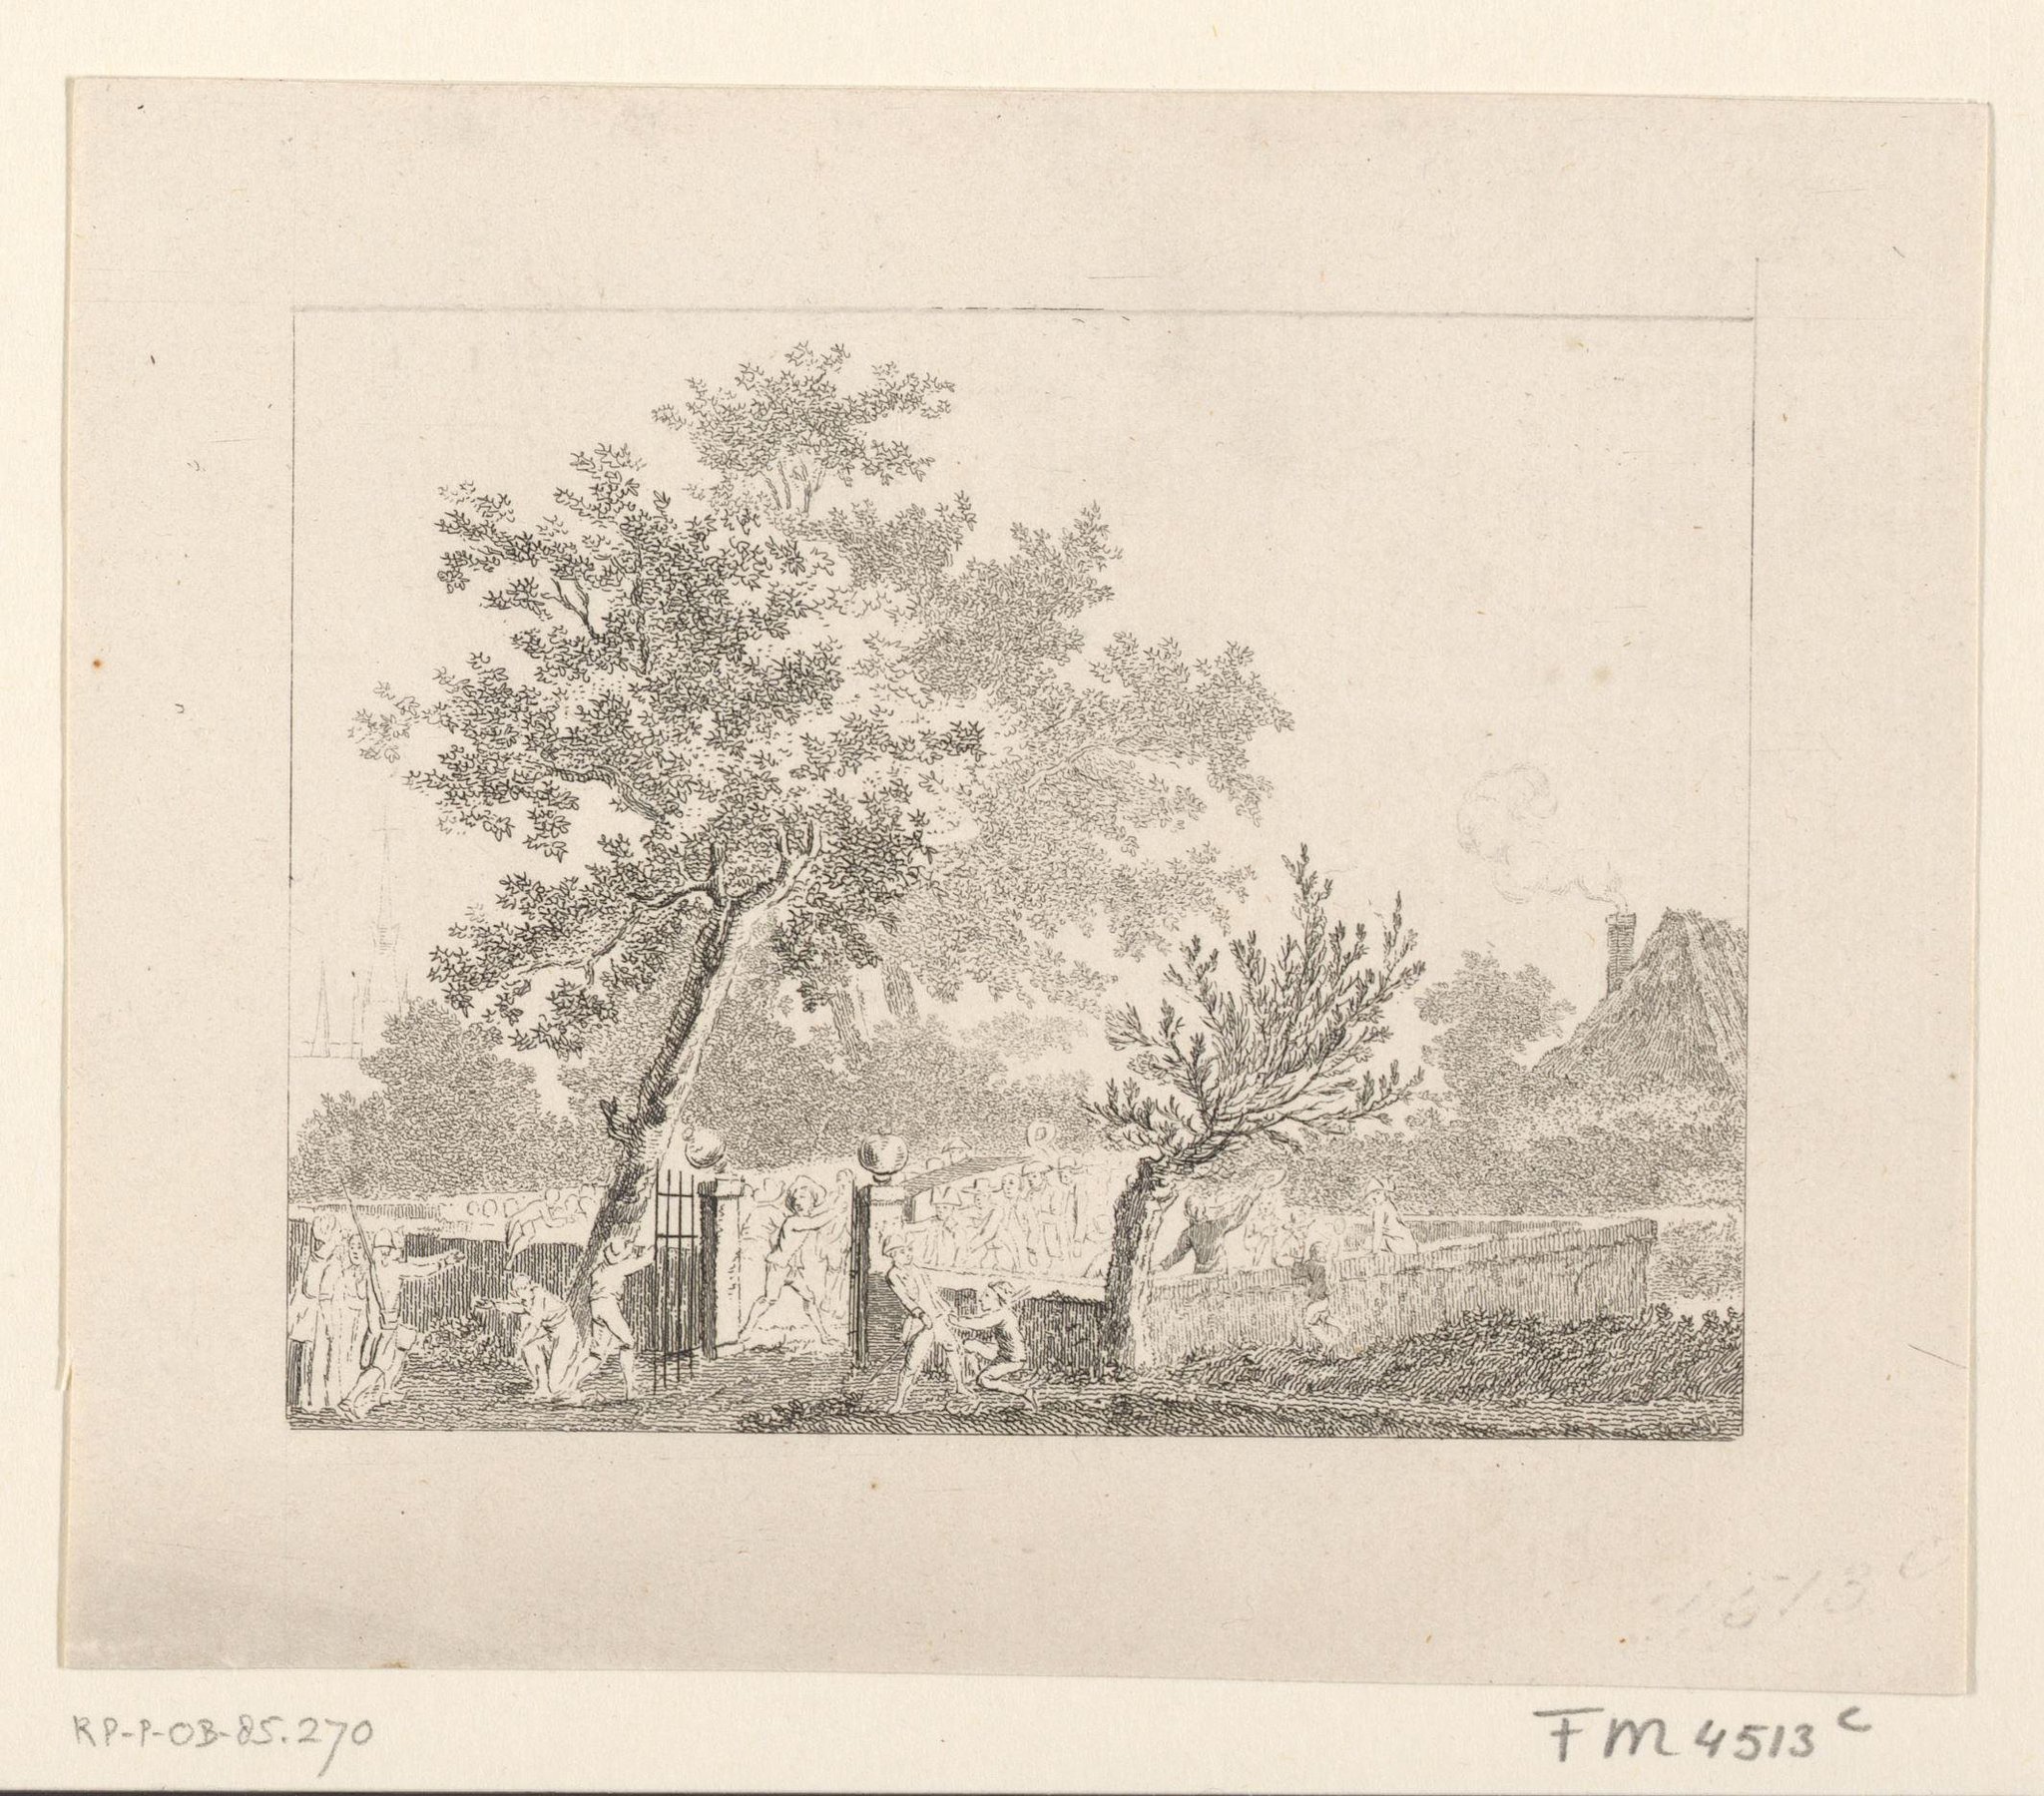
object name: print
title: Herbegrafenis van de vrouw te Arnhem, 1783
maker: mathias de sallieth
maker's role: print maker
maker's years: 1749-1791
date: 1787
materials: paper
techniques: etching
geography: northern netherlands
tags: opening of grave, exhumation, arnhem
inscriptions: collector's mark: Lugt 2228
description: Herbegrafenis van de vrouw te Arnhem, 4 augustus 1783. Fragment van een grotere plaat met de titel 'Atlas der Geschiedenissen van onzen tyd. Plaat I'. Dit was een proefaflevering van een nieuwe reeks voorstellingen van historische gebeurtenissen uit de jaren 1780-1787, de reeks is na dit eerste nummer niet voortgezet.